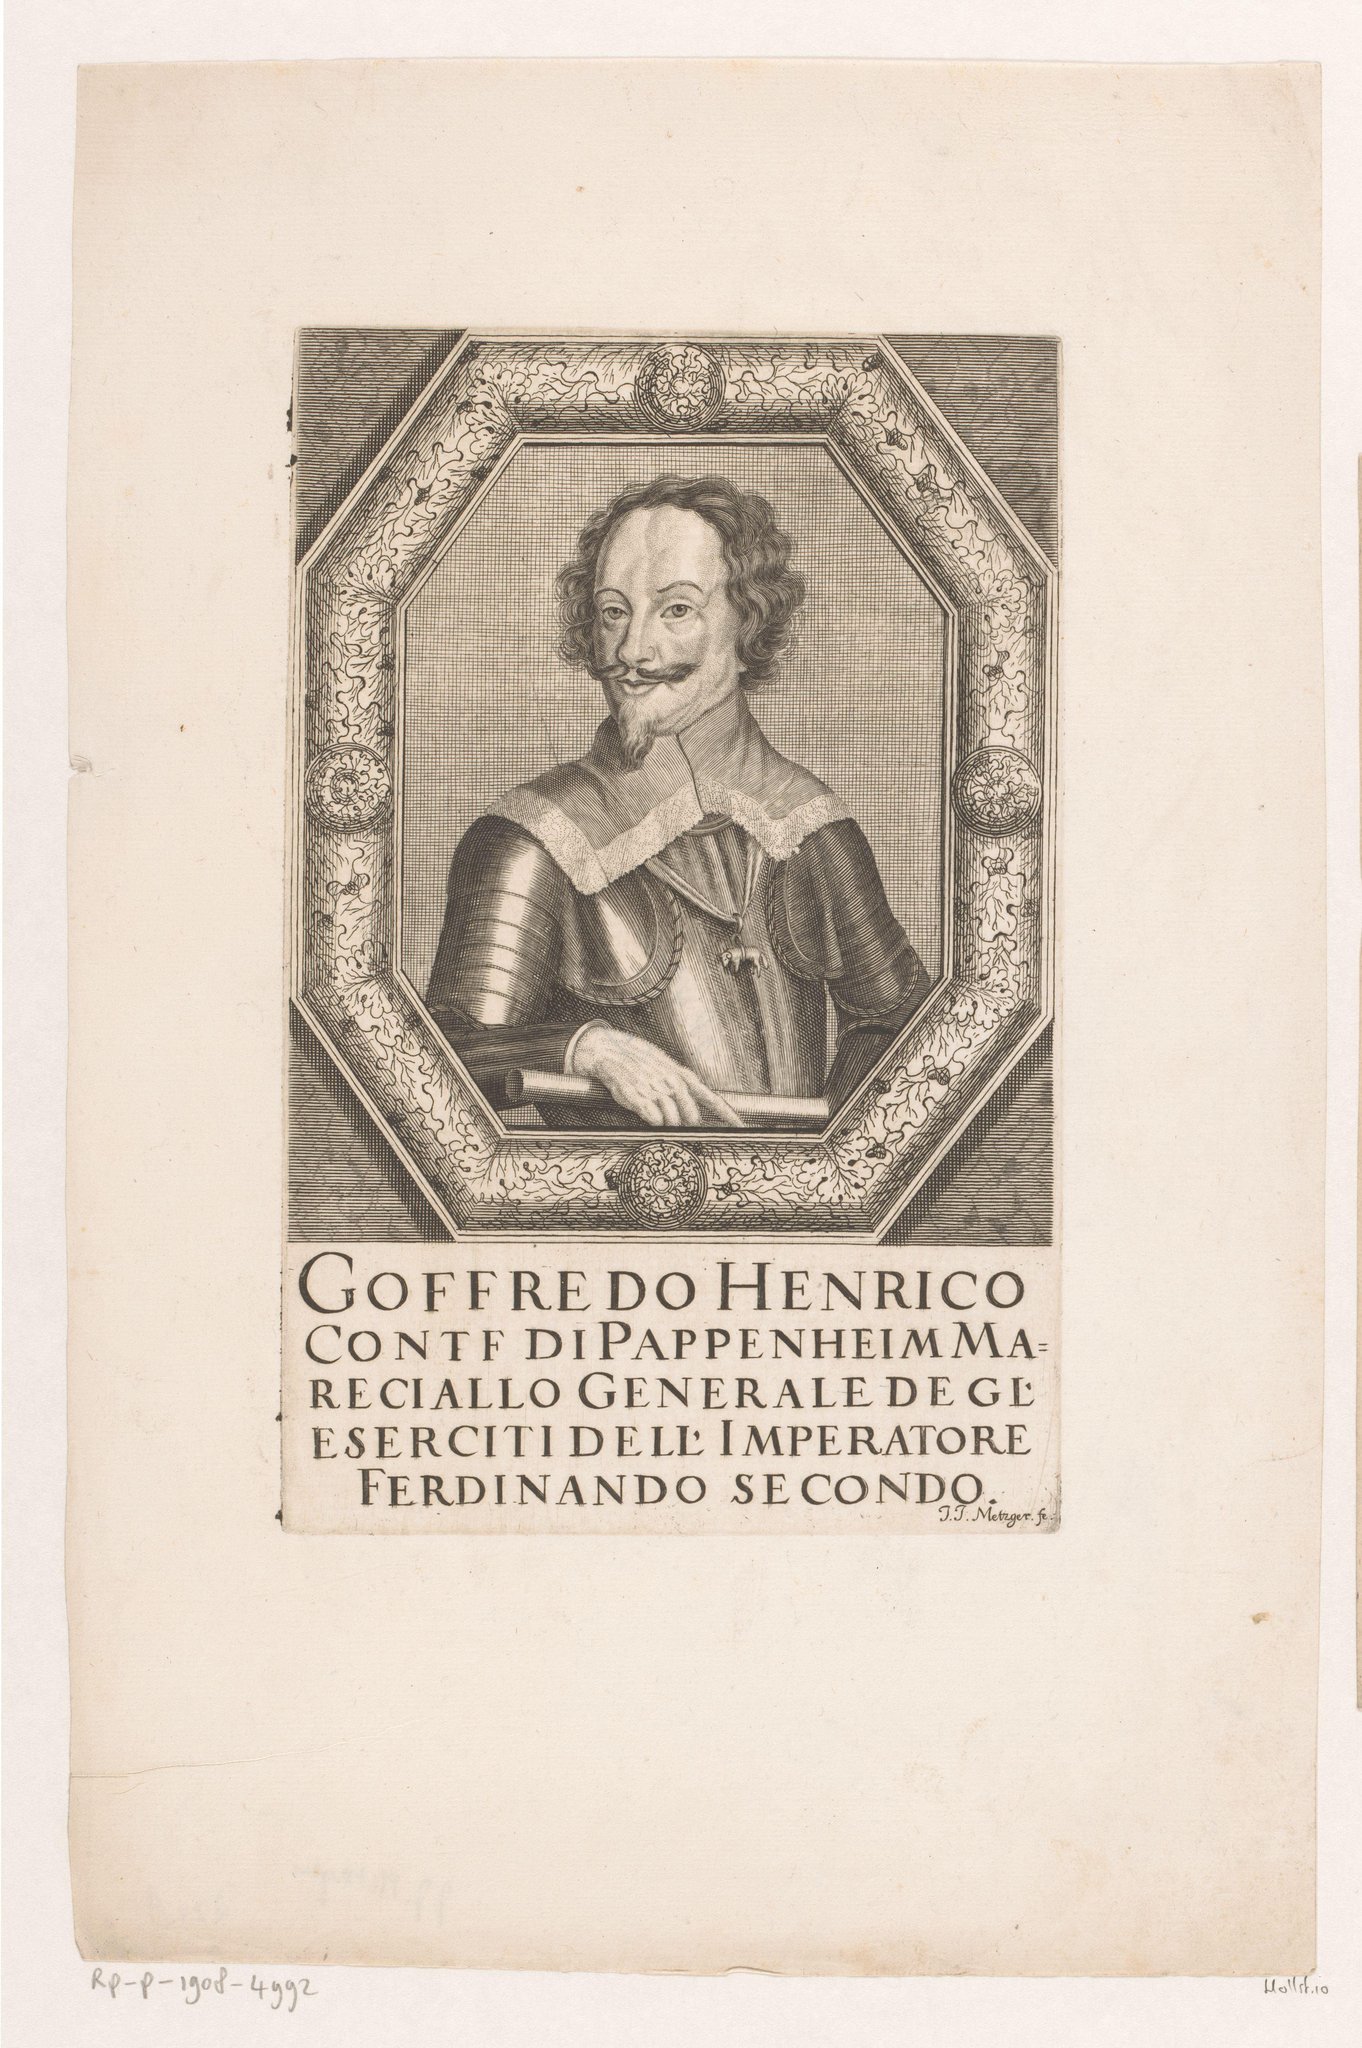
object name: print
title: Portret van Gottfried Heinrich graaf zu Pappenheim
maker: johann jakob metzger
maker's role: print maker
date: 1673-1675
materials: paper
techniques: engraving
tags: armour, historical persons, knighthood order of the golden fleece, baton of general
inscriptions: collector's mark: Lugt 2228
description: Prent ook gebruikt in: Galeazzo, Gualdo Priorato. Vite et azzioni di personaggi militari e politici. Wenen: Thurnmayer, 1673.